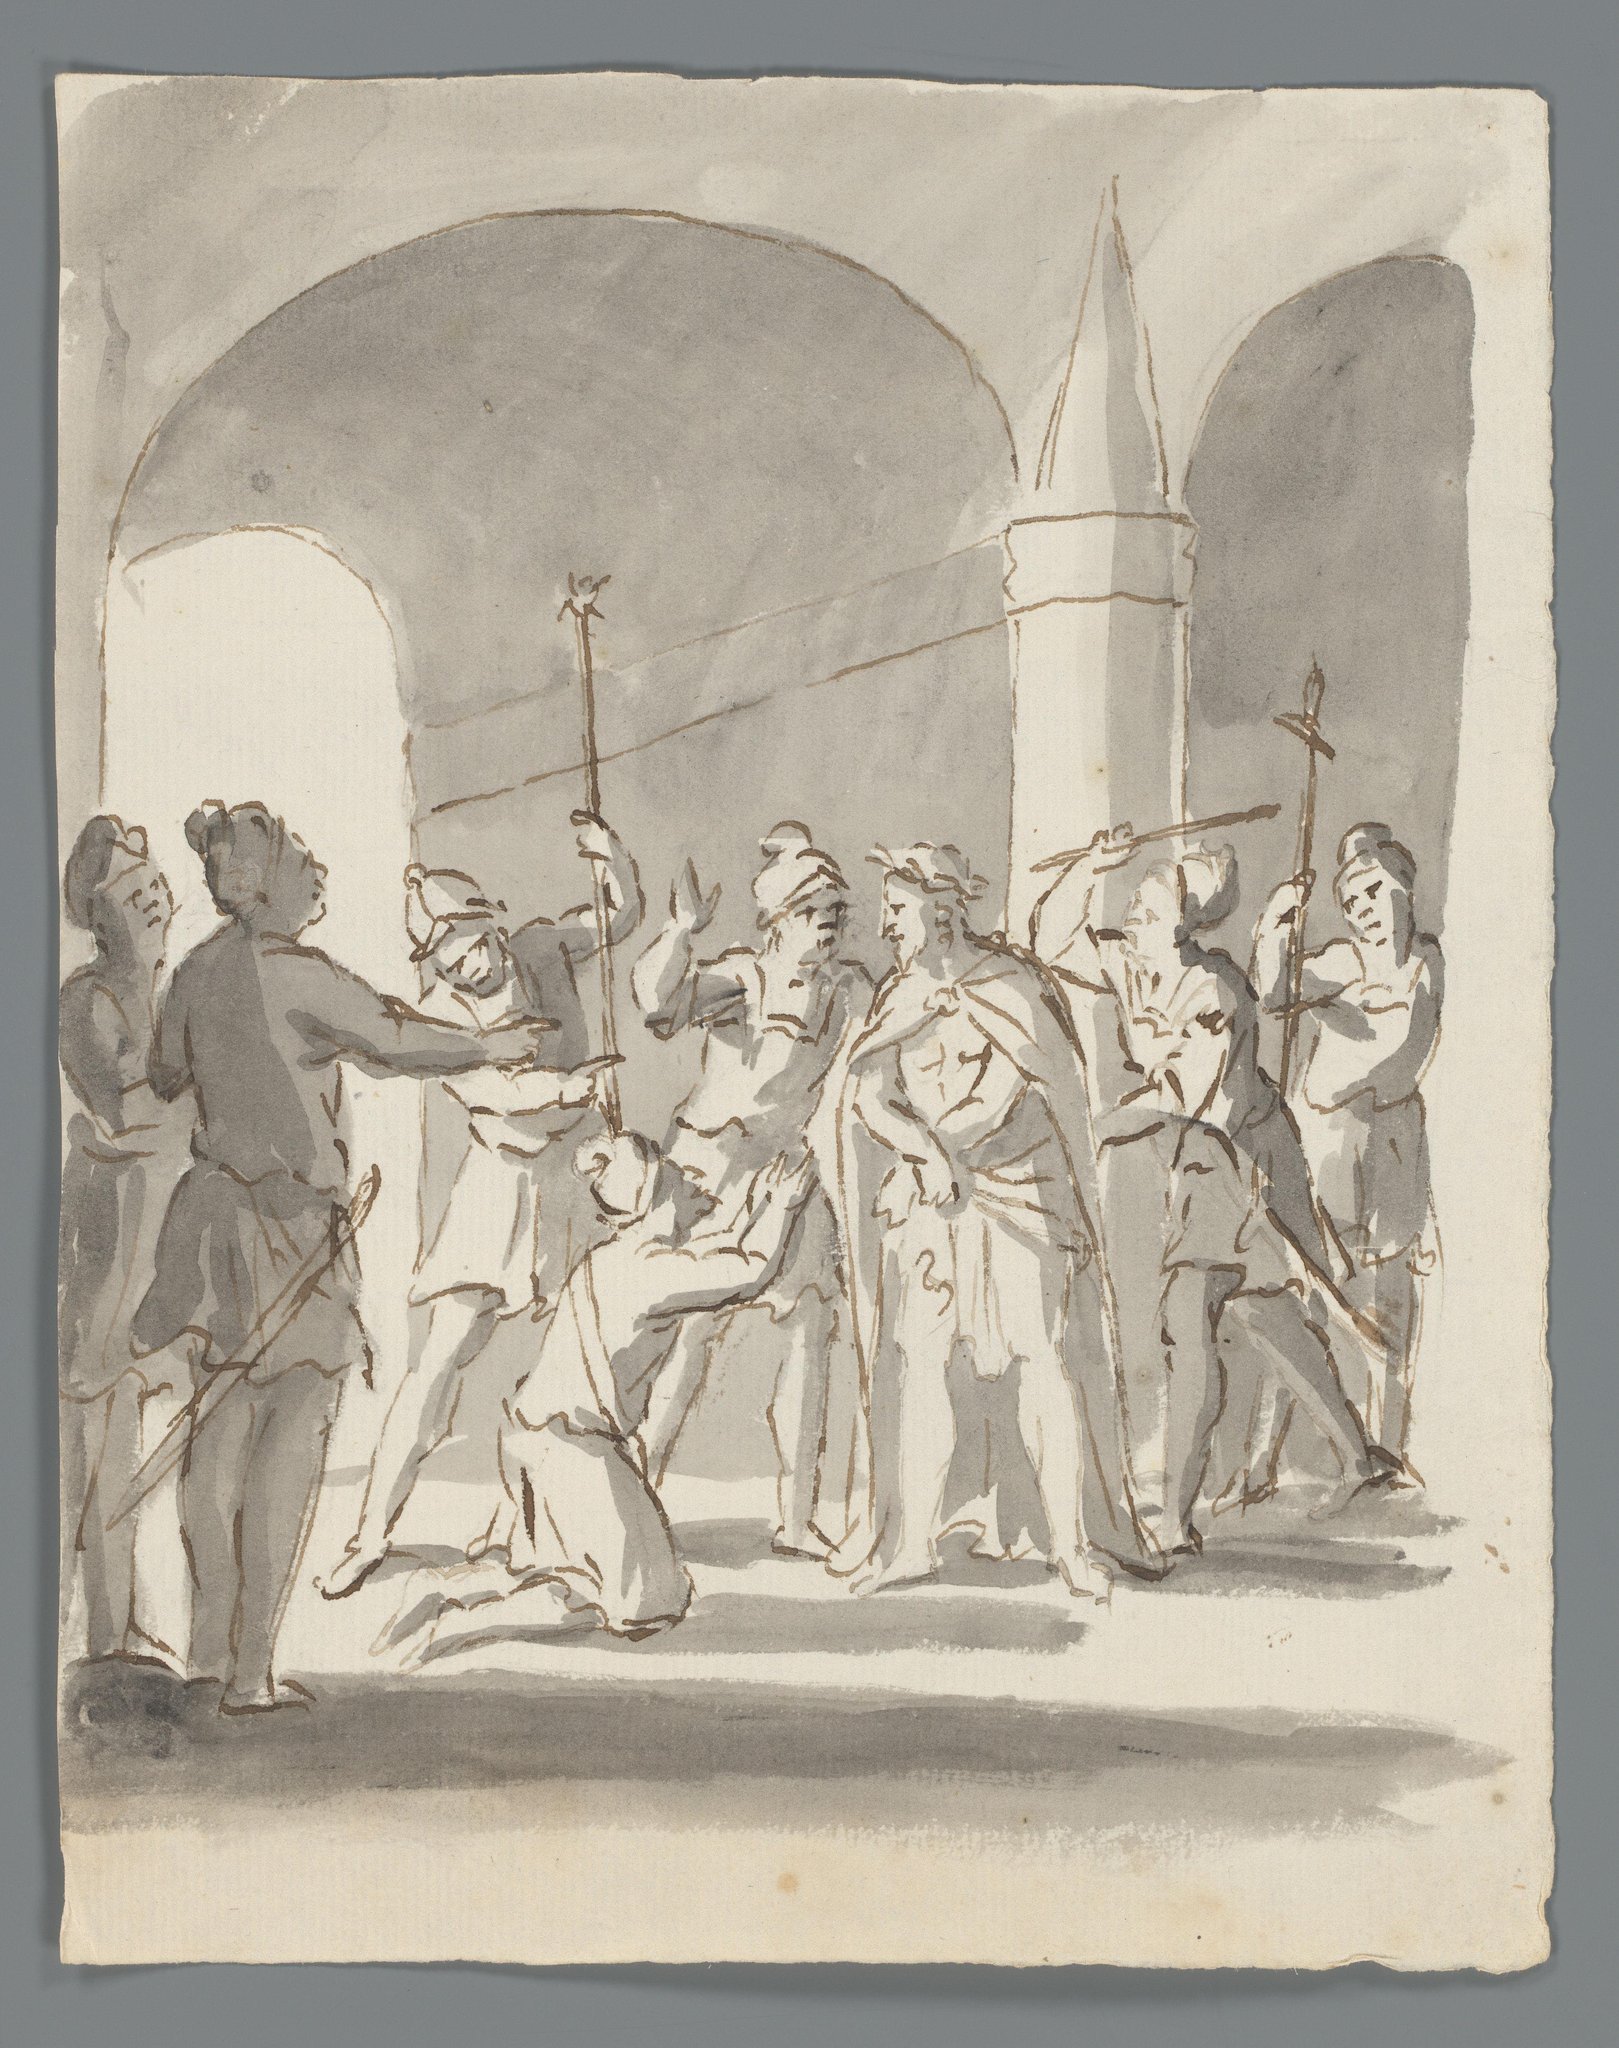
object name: drawing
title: Bespotting van Christus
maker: matthijs balen (1684-1766)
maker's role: draughtsman, painter, print maker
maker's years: 1684-1766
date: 1694-1766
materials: paper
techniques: brush, pen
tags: in pilate's palace christ is mocked by soldiers (luke 22:63-65)